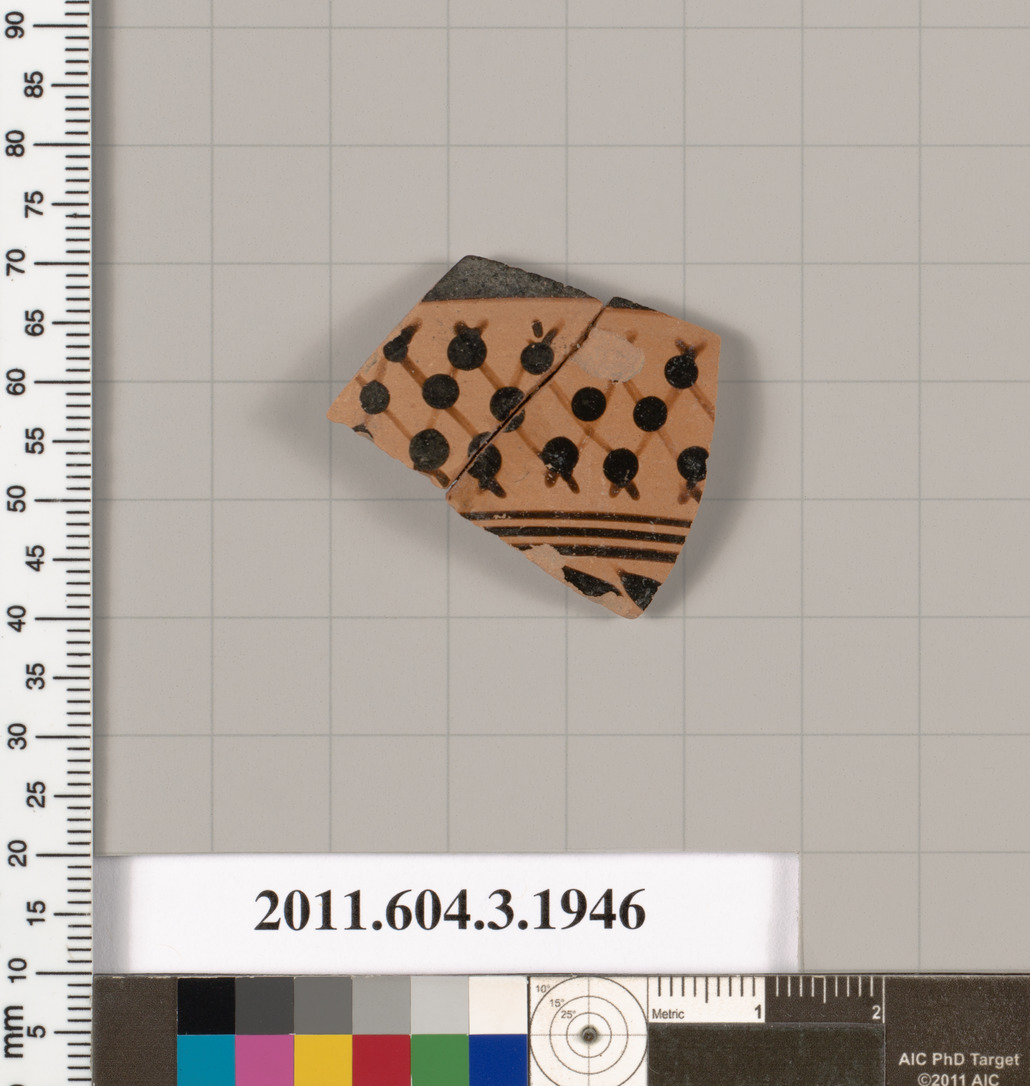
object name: kylix fragment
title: Terracotta fragment of a kylix: Cassel cup (drinking cup)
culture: greek, attic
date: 550-526 BCE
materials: terracotta